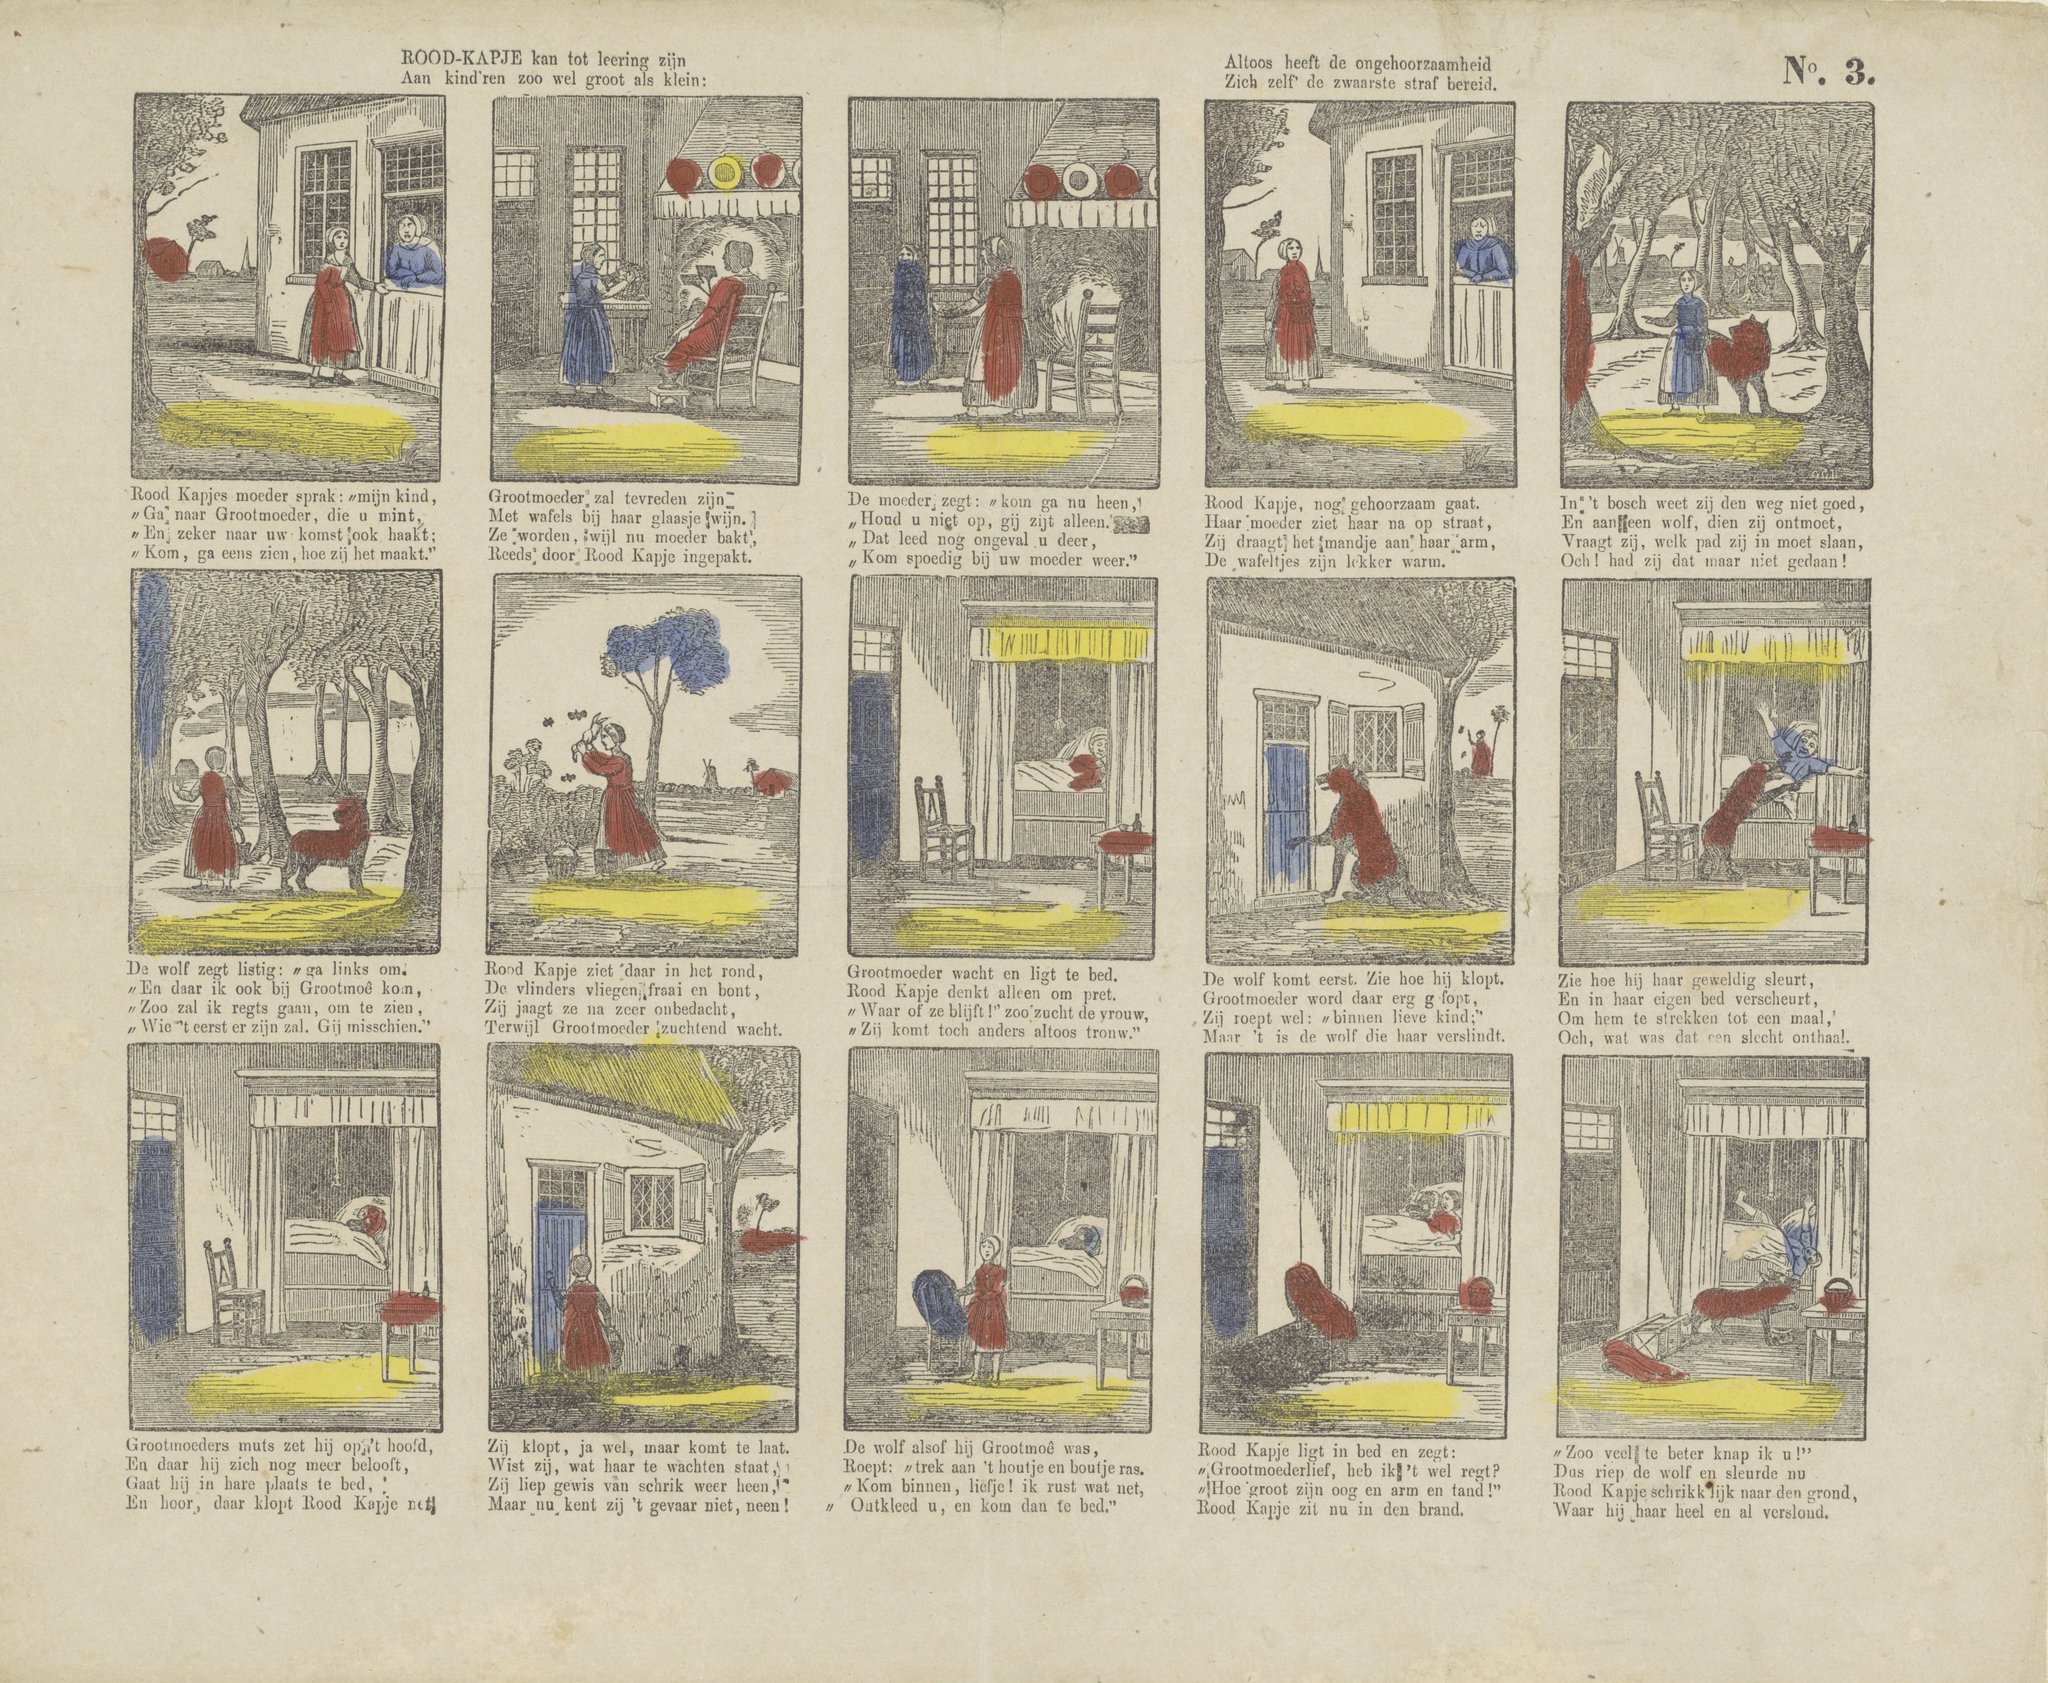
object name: popular print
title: Rood-kapje kan tot leering zijn / Aan kind'ren zoo wel groot als klein: / Altoos heeft de ongehoorzaamheid / Zich zelf de zwaarste straf bereid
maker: monogrammist gcb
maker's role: print maker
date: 1850-1870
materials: paper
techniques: colour, letterpress printing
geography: netherlands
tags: tales and fairy tales: little red riding-hood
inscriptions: collector's mark: Lugt 2760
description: Blad met 15 voorstellingen uit het sprookje van Roodkapje. Onder elke afbeelding een vierregelig vers. Rechtsboven genummerd: No. 3.